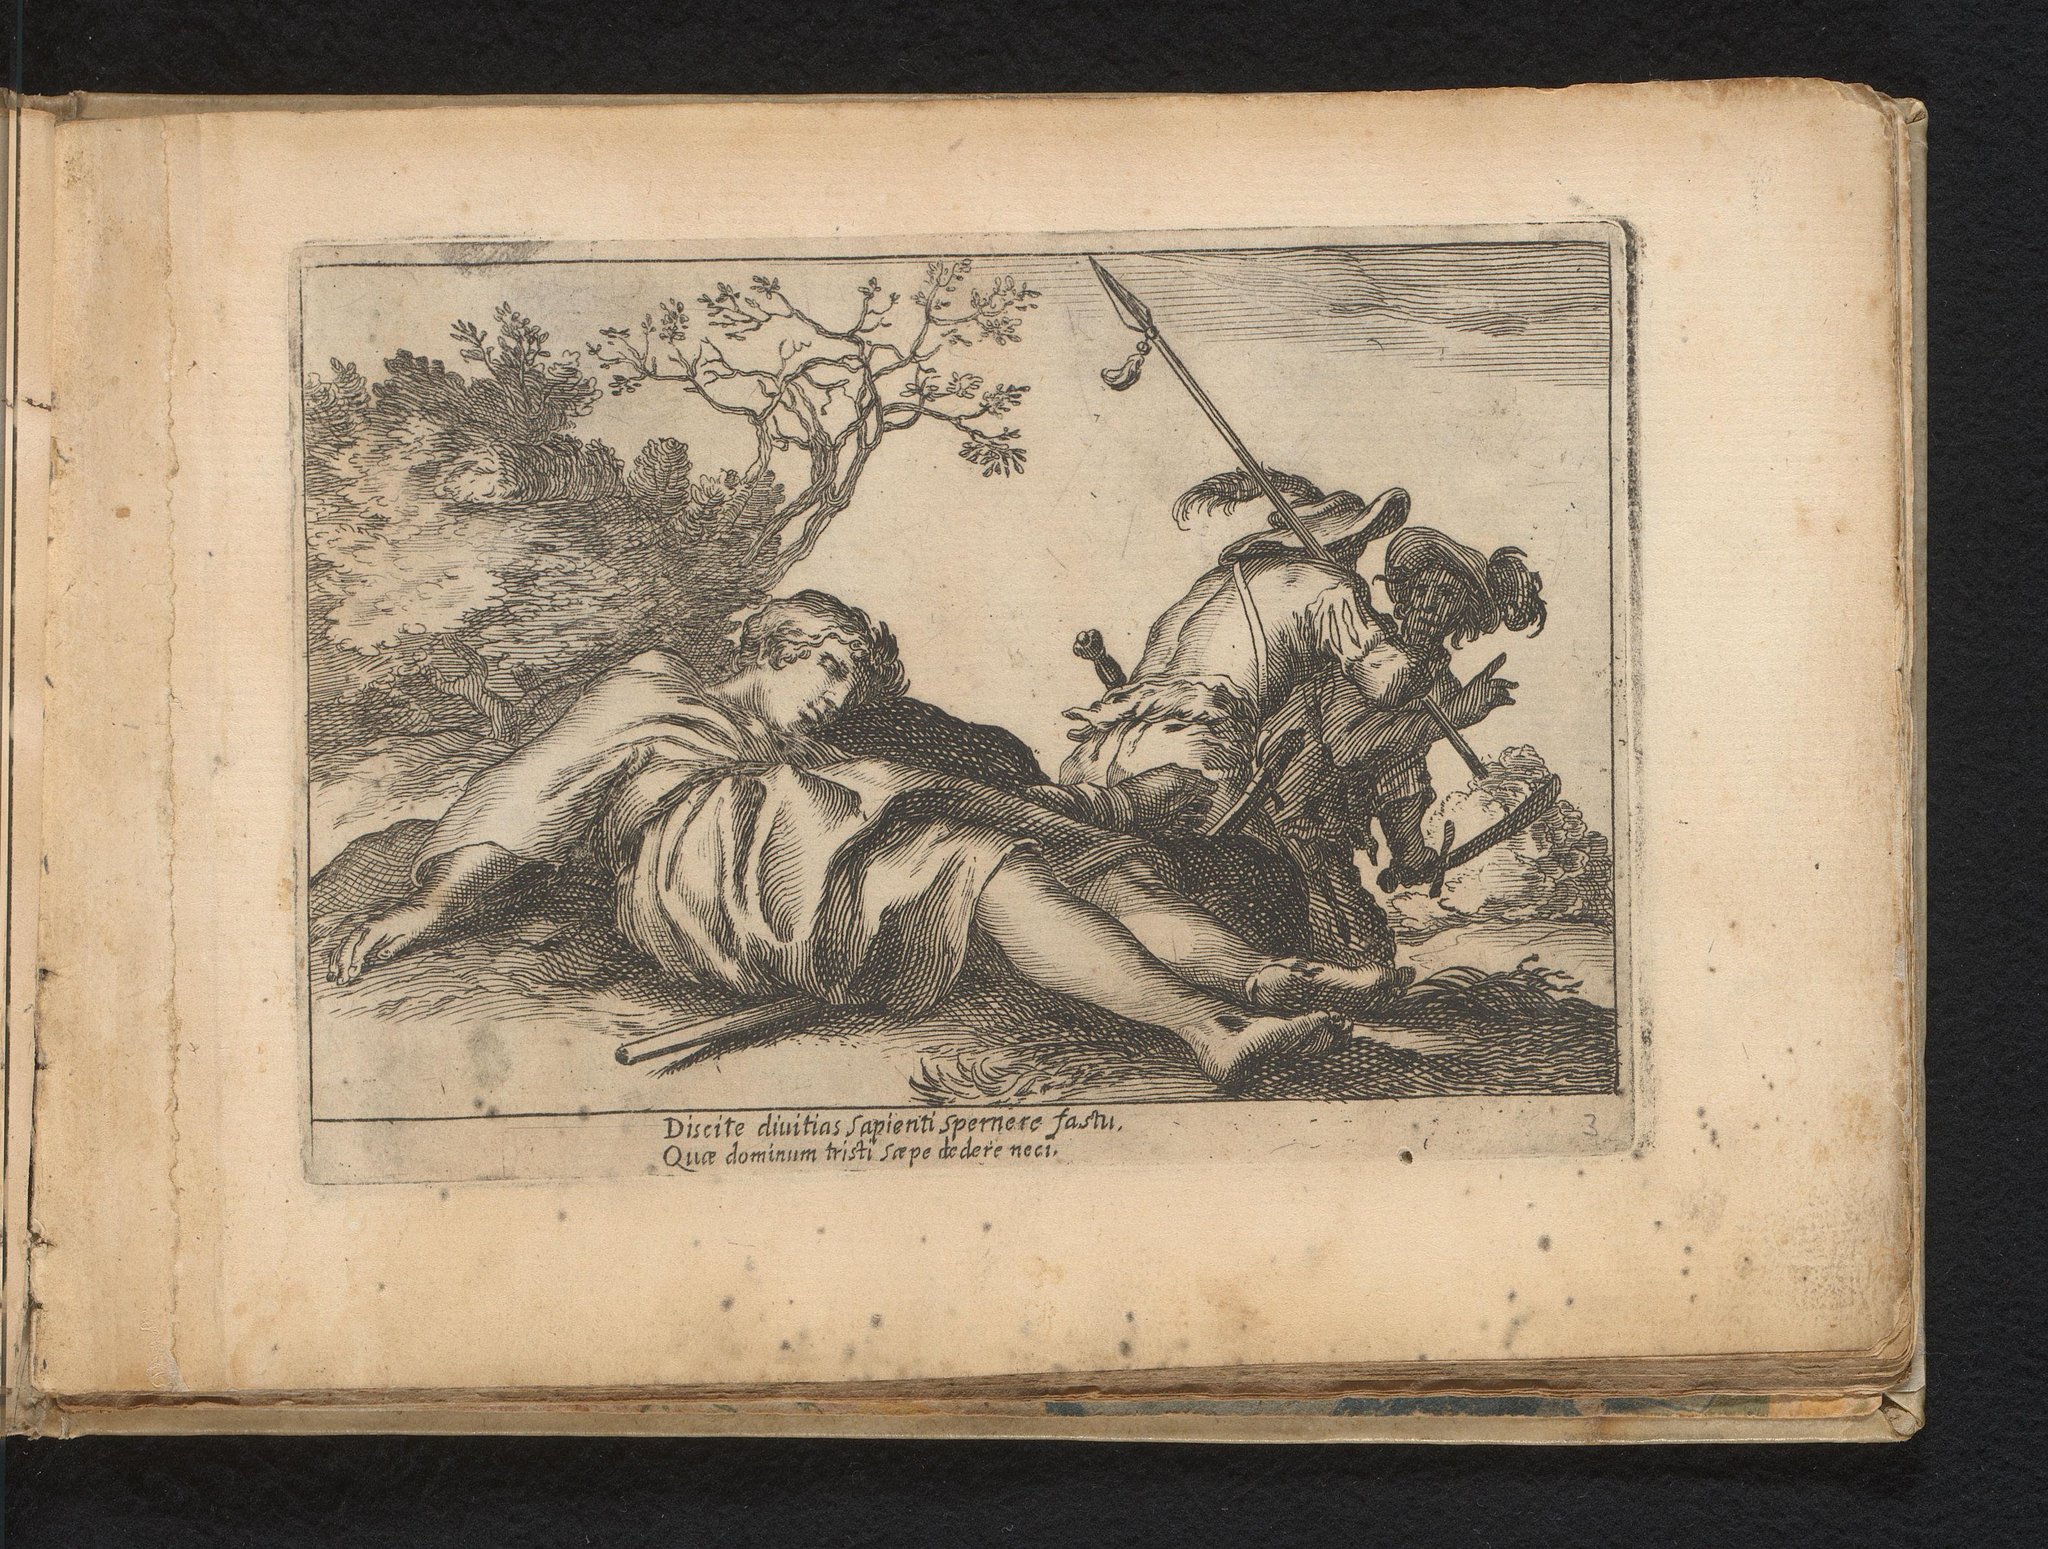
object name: print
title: Herder en moordenaars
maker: Anonymous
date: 1629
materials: ink, paper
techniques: engraving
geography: utrecht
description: Een herder ligt op de grond. Op de achtergrond vertrekken twee soldaten haastig. De ene heeft zijn zwaard getrokken. Met tweeregelig vers in het Latijn in ondermarge. Prent uit album met een serie van 16 ingebonden prenten met pastorale scènes. Het betreft de serie getiteld: Otia delectant faciuntq [...]. Kalfsleren band met opschrift en decoratieve kaderlijnen in pen in bruin. Voorin en achterin vier schutbladen van velijn.